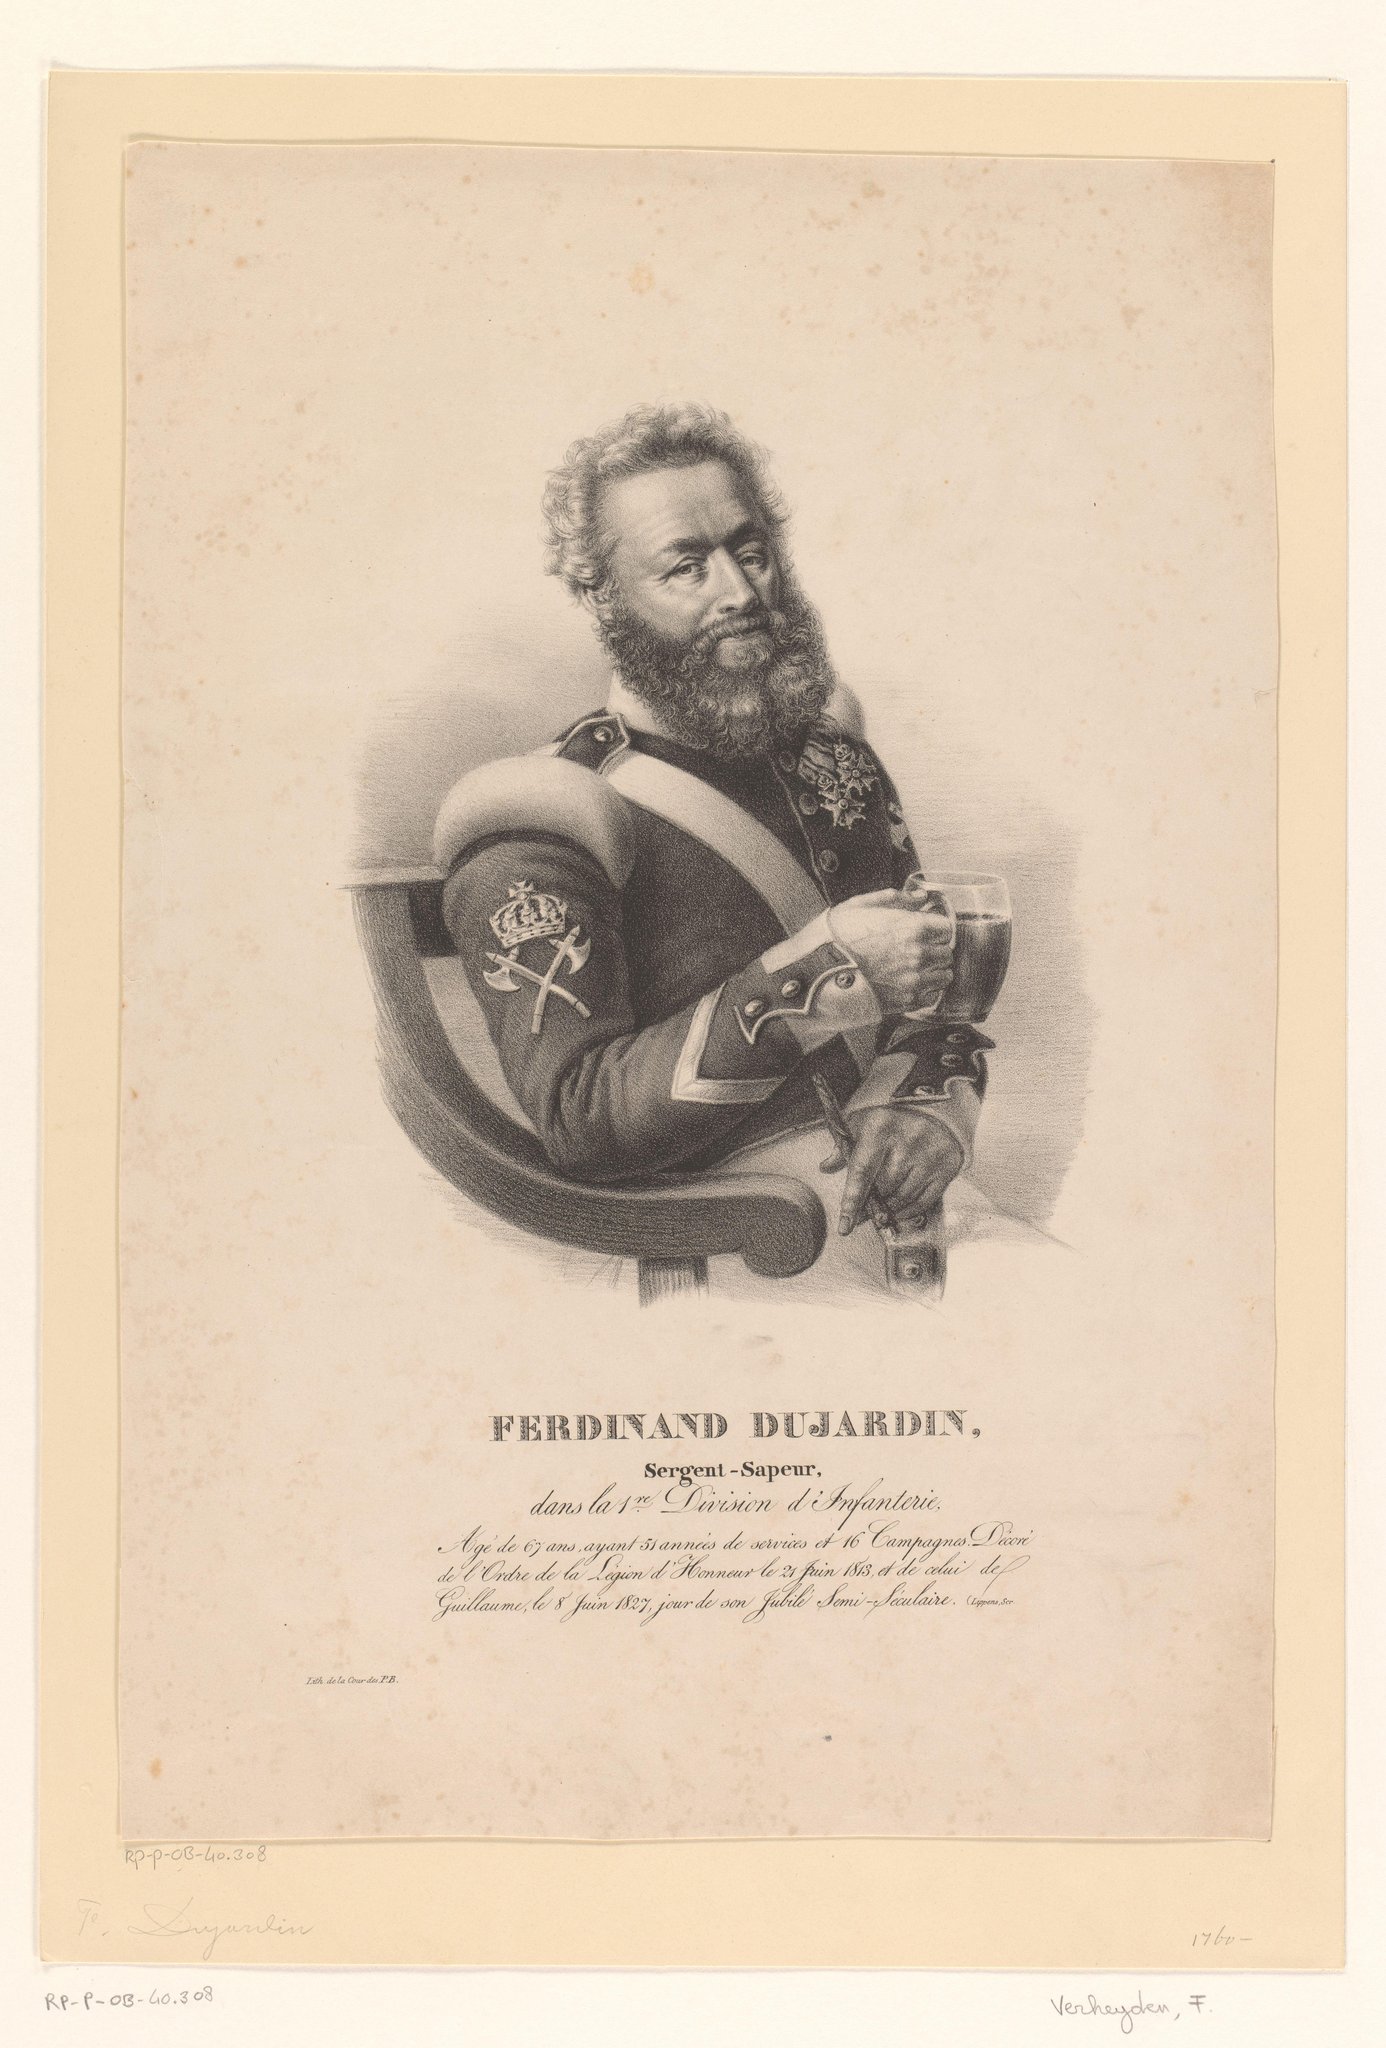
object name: print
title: Ferdinand Dujardin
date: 1827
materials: paper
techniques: lithograph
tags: ranks in the army, historical persons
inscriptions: date